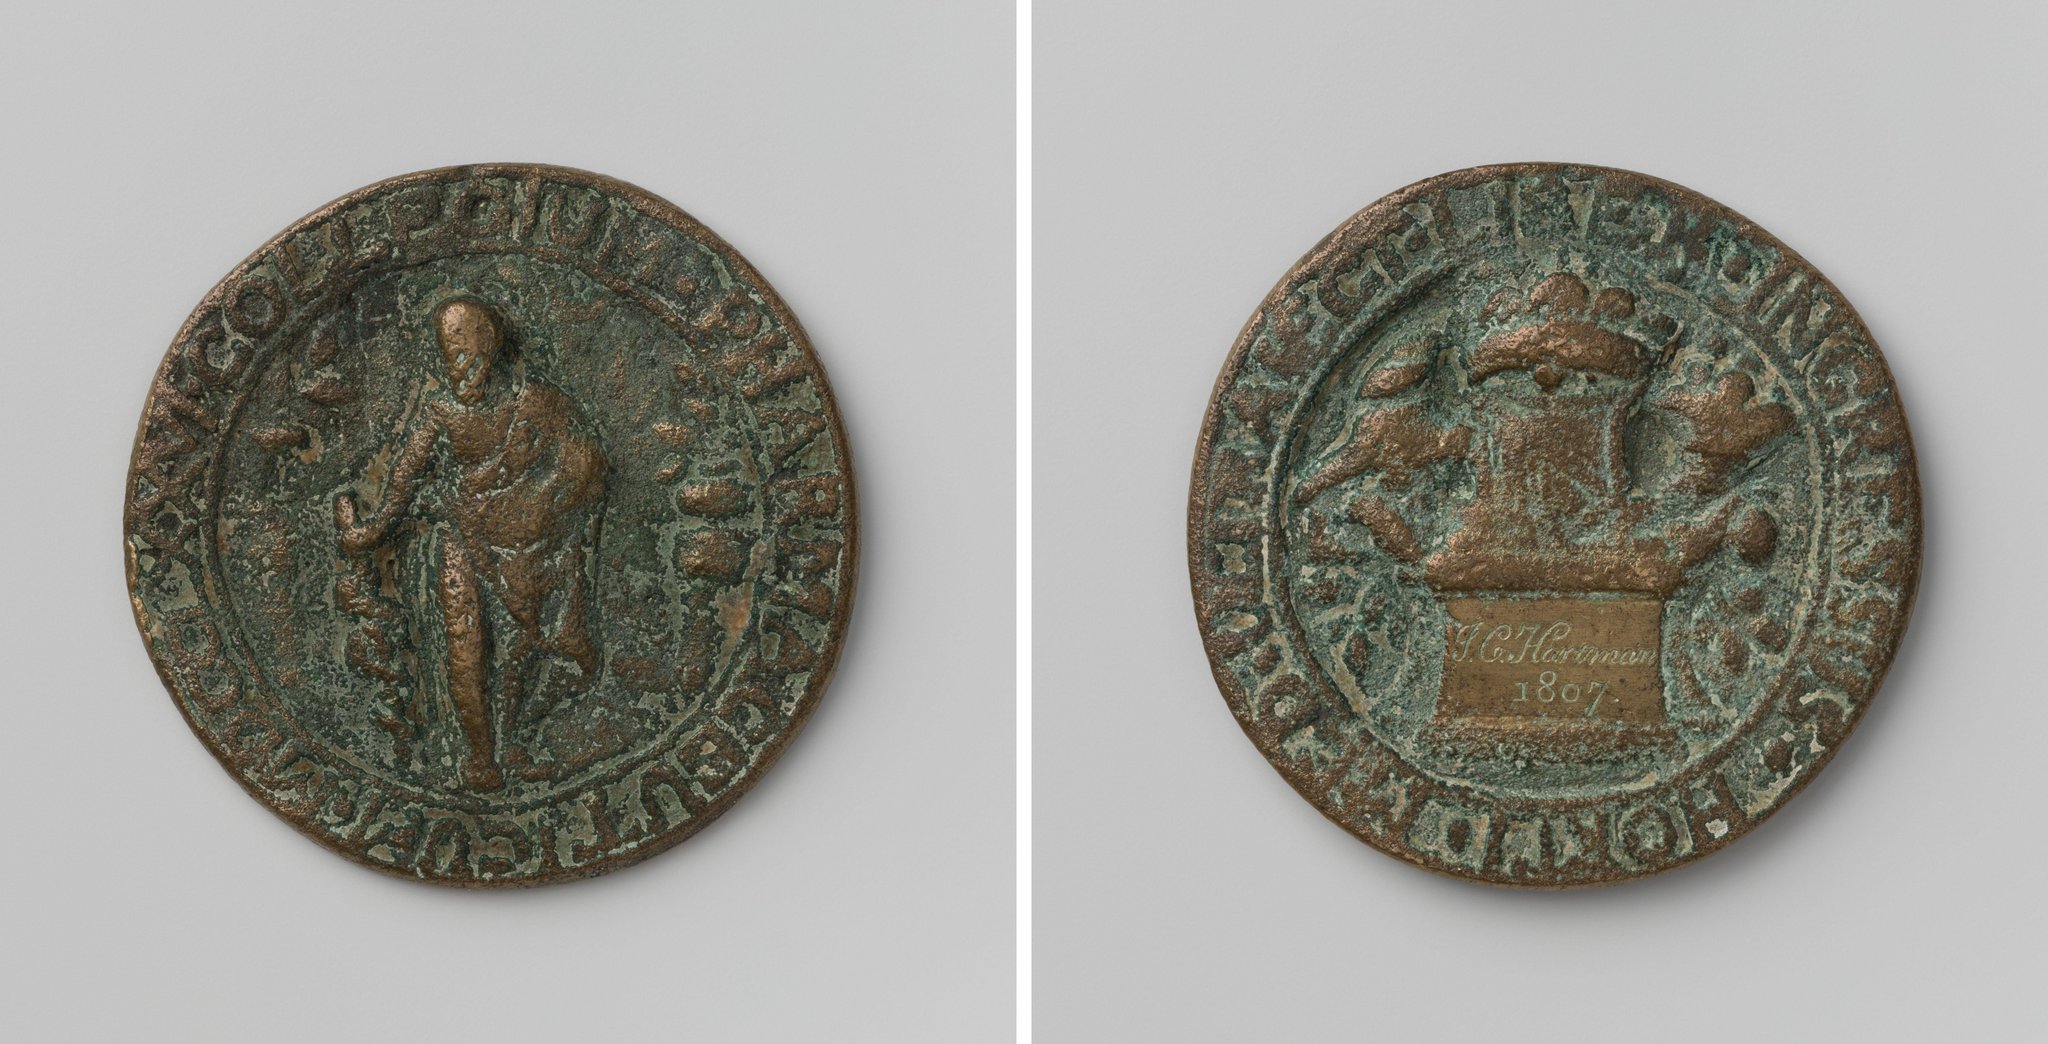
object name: toegangspenning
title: Collegium Medicum te Utrecht, toegangspenning voor de hortus medicus voor J.C. Hartman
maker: Anonymous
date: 1807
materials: brass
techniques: casting, engraving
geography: utrecht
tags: utrecht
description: Messing penning. Voorzijde: Aesculapius met rechterhand leunend op slangestaf en linkerhand onder zijn mantel, staande tussen twee vazen met planten op voetstuk; op achtergrond wand van gebouw binnen omschrift. Keerzijde: gekroond wapenschild tussen twee gevulde hoorns van overvloed boven zalfspatel, waarom slang zich kronkelt, liggend op voetstuk met opschrift binnen omschrift